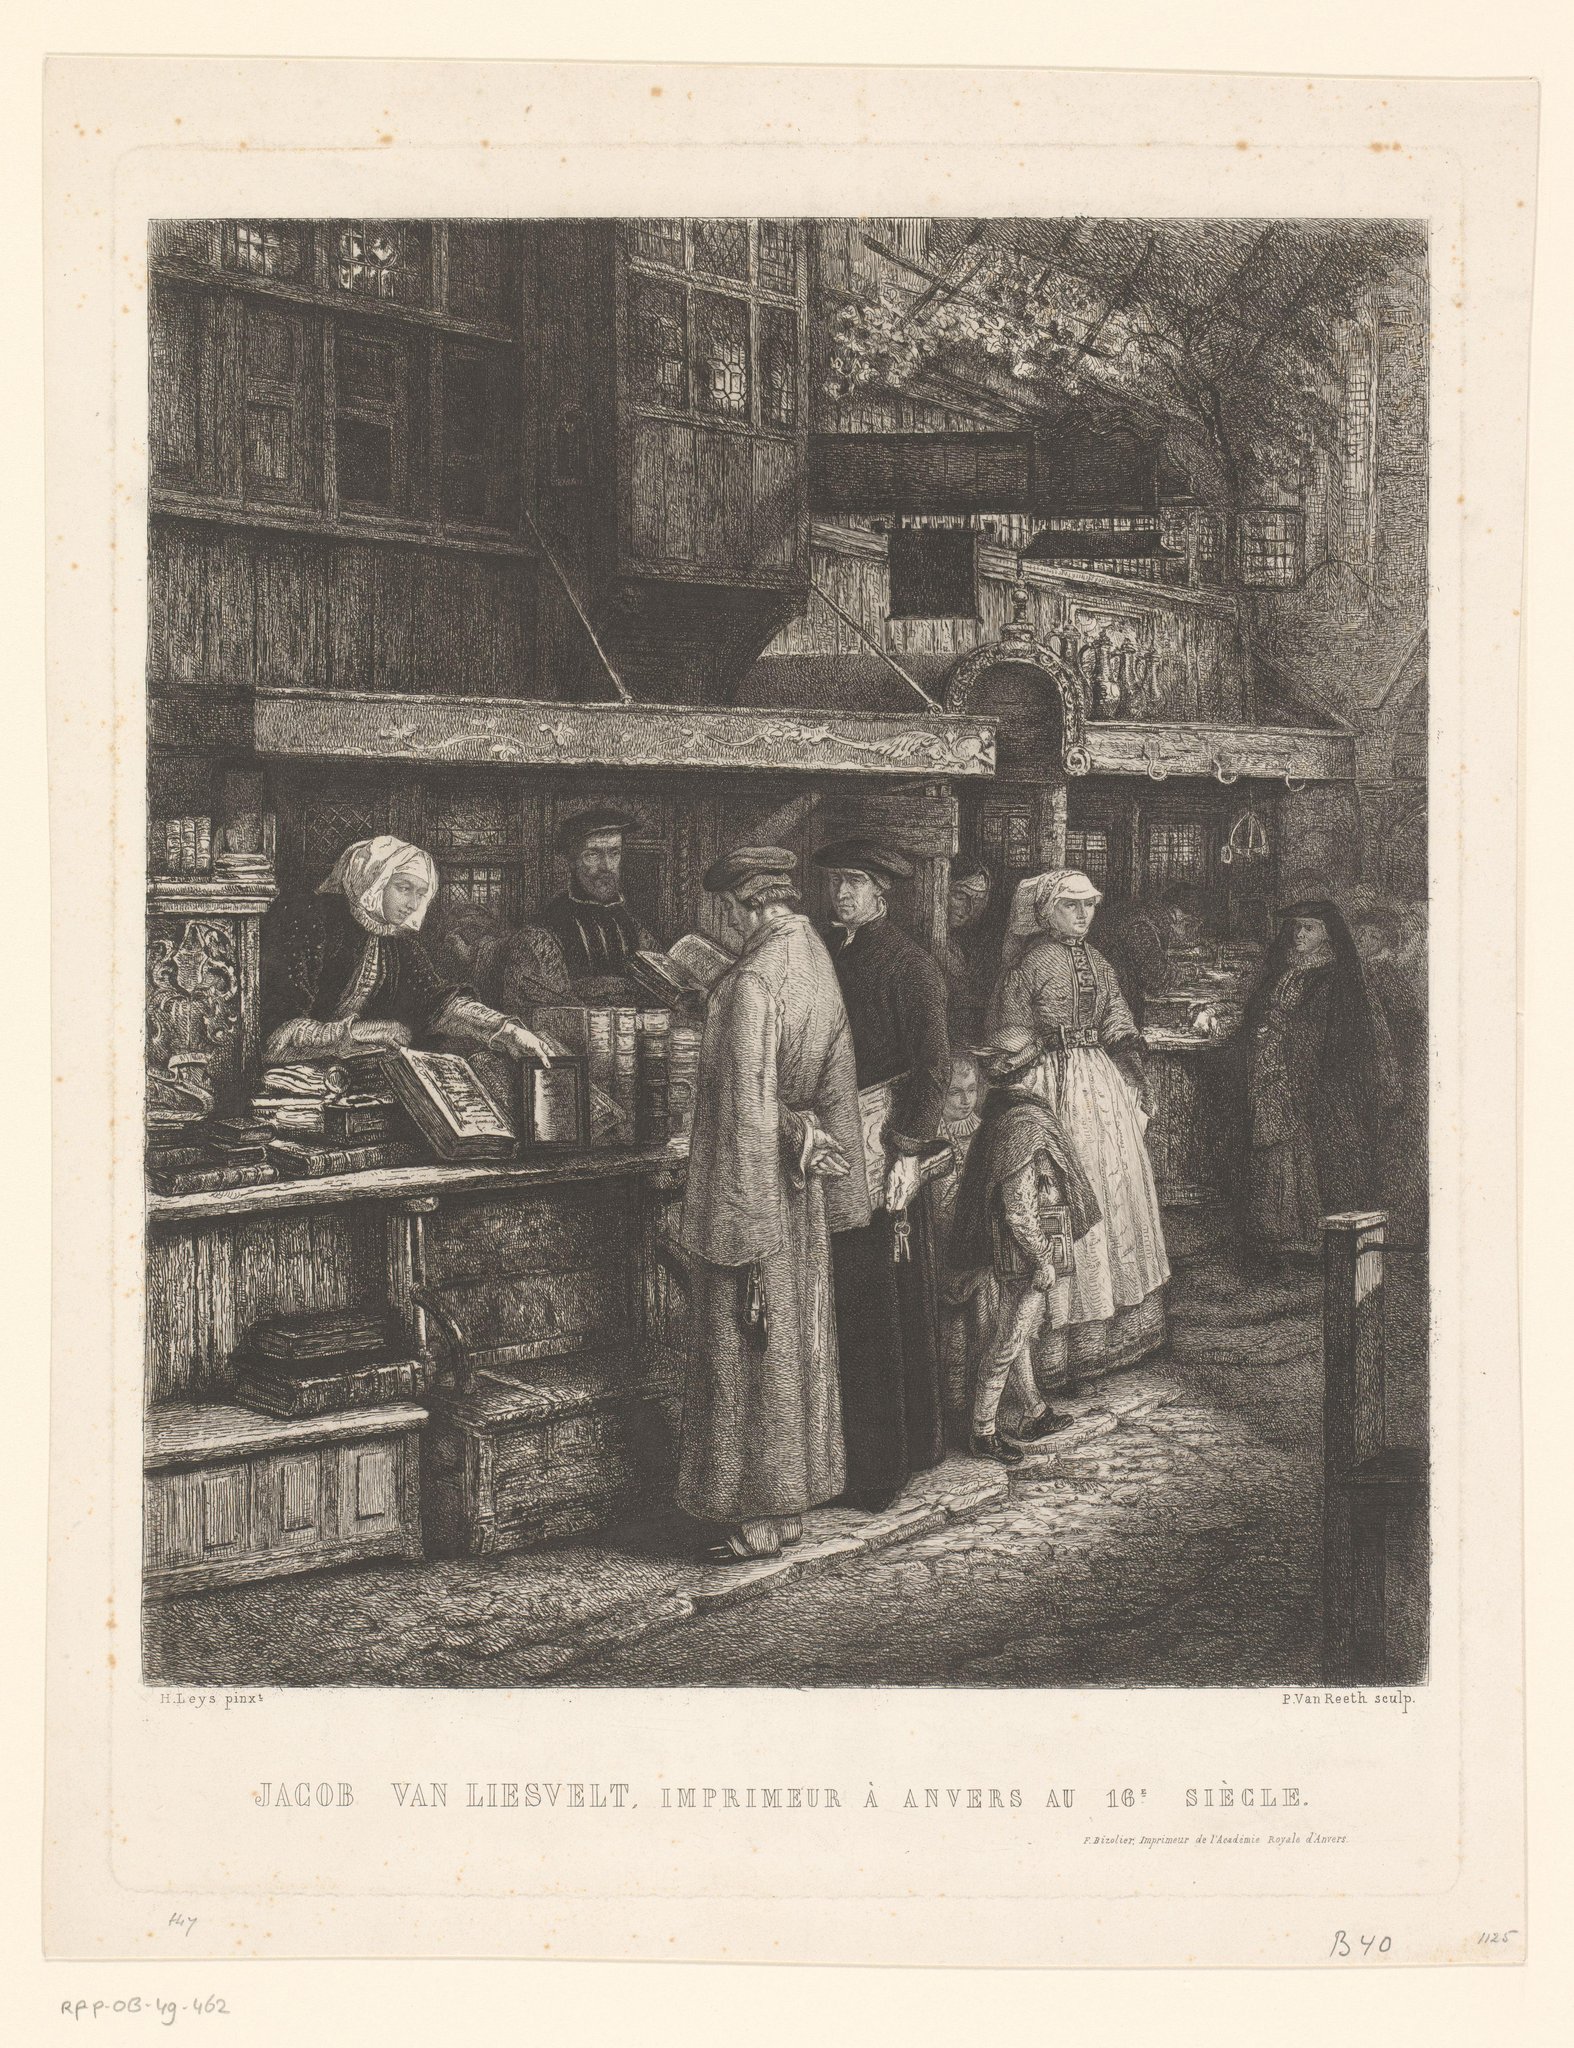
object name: print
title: Gezicht op de boekwinkel van Jacob van Liesvelt te Antwerpen in de zestiende-eeuw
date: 1853-1866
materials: paper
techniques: etching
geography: antwerp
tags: printer, house combined with shop, street, book-shop, bookseller, antwerp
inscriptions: collector's mark: Lugt 2228